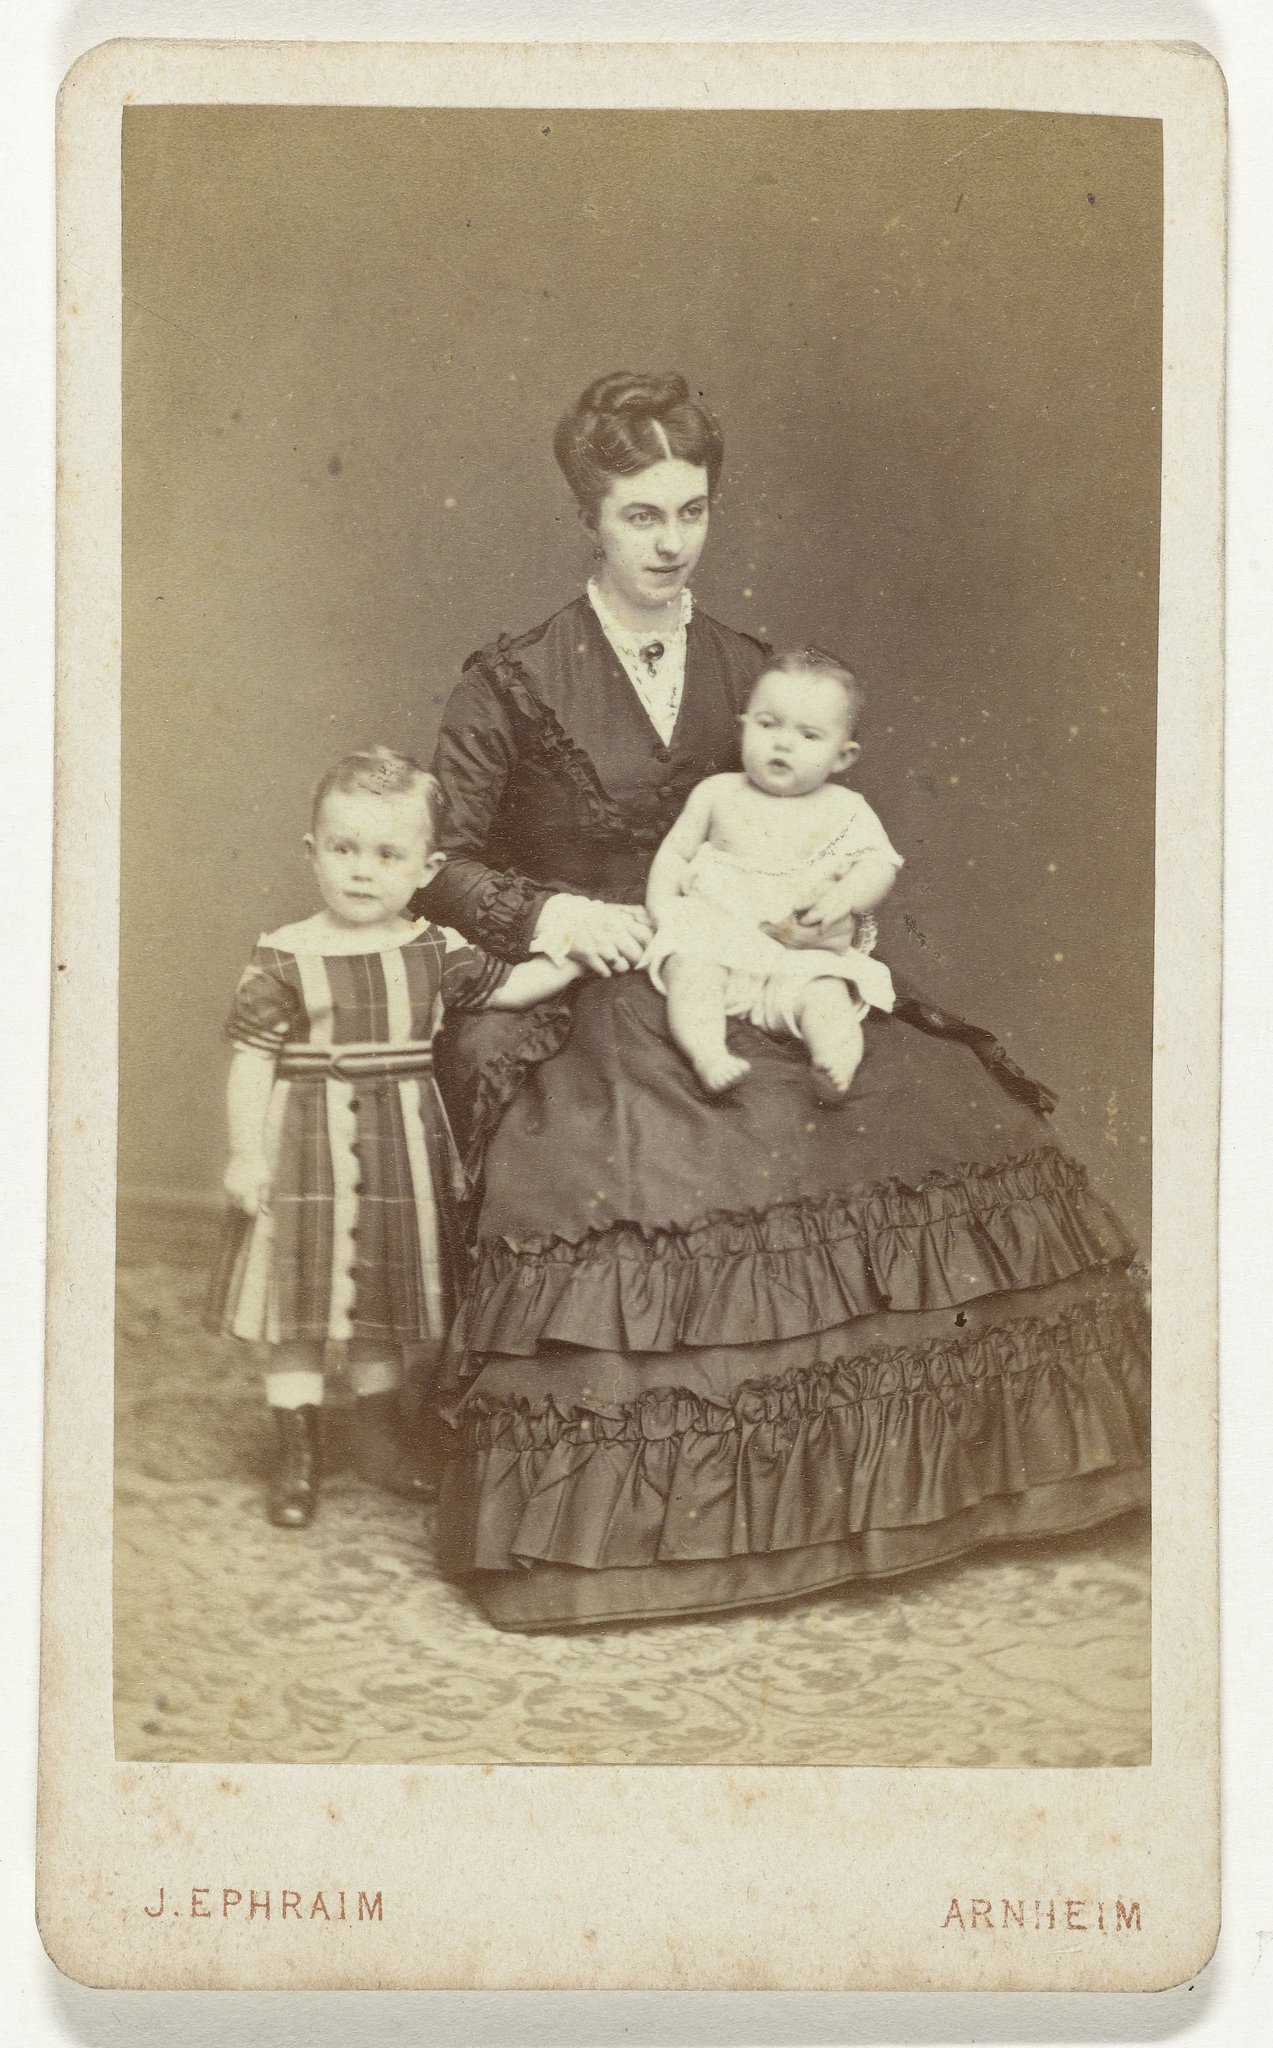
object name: carte de visite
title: Portret van een moeder met twee kinderen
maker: johannes ephraim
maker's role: fotograaf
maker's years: 1838-1921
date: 1865-1870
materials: cardboard, paper, photographic support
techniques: albumen print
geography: arnhem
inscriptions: address: ‘J. Ephraim/Rynkade. 311 & 312/Arnhem’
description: Een zittende vrouwmet een baby op schoot en een kleuter staand naast haar stoel.